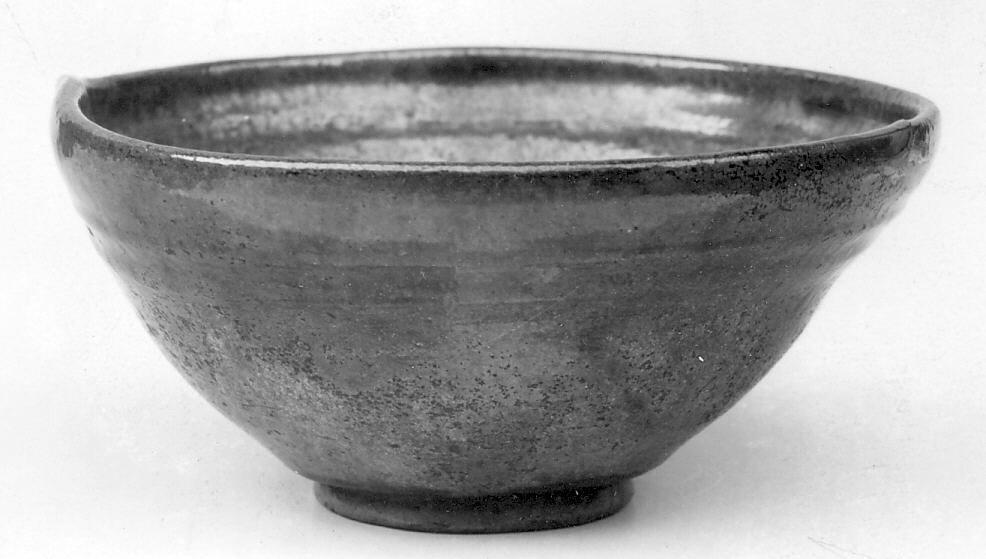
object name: teabowl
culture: japanese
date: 1800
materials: glaze